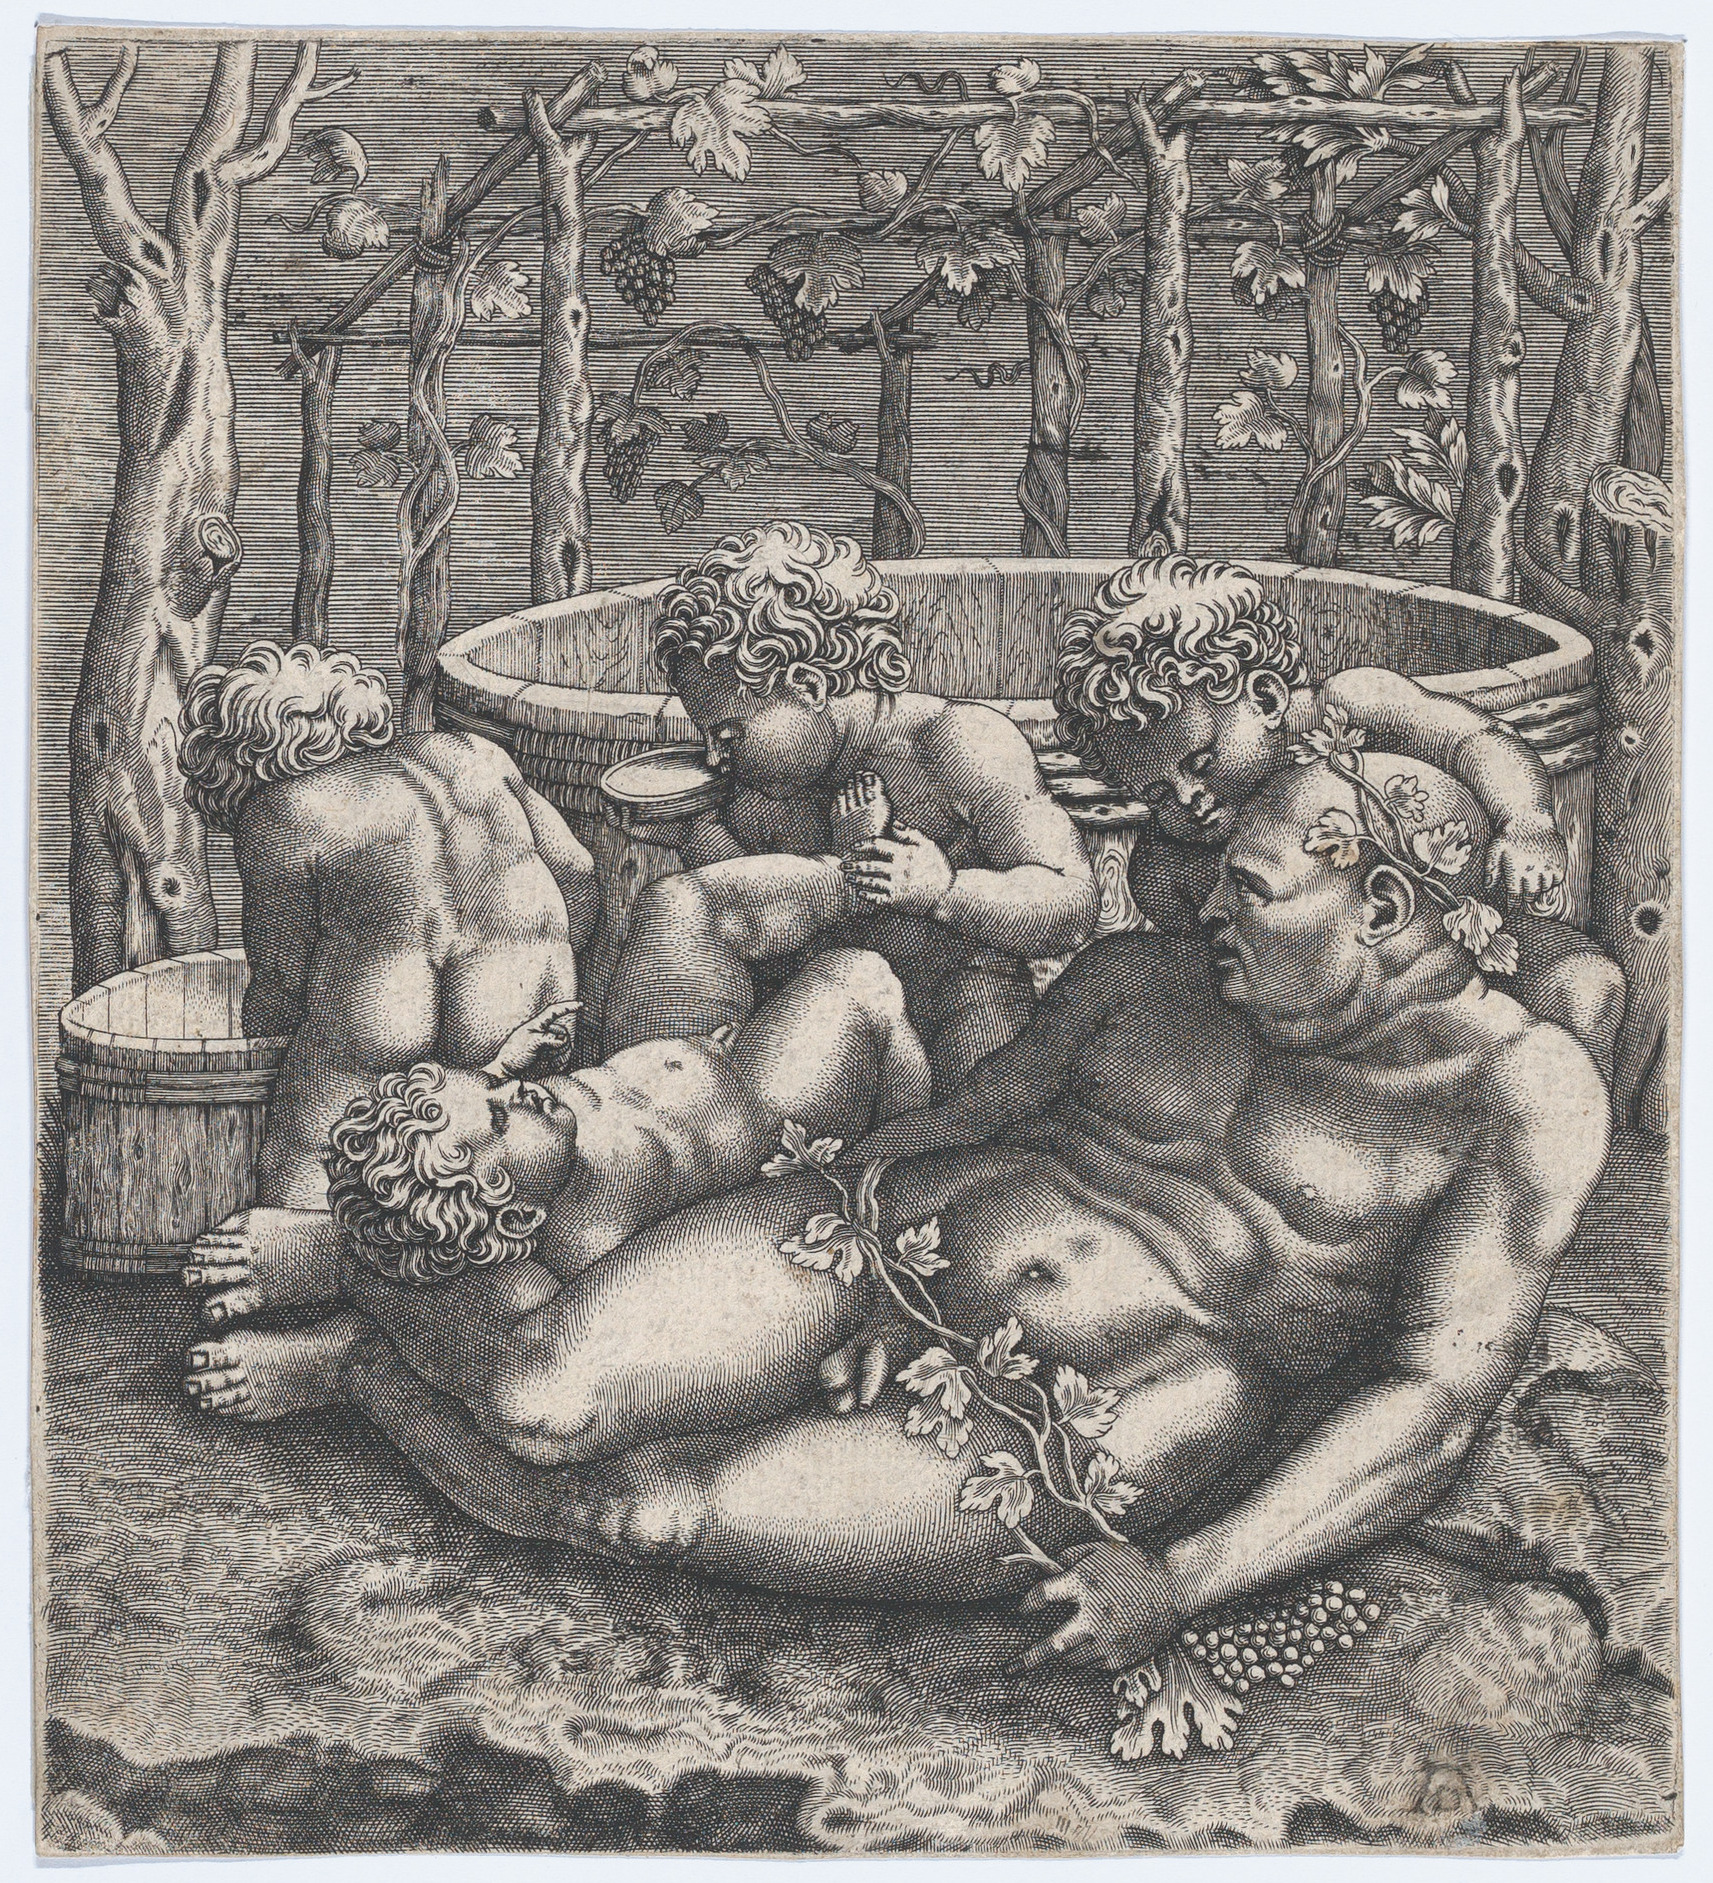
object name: print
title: The drunken Silenus with putti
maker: anonymous, italian, 16th century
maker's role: artist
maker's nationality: italian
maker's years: 1500-1600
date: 1515-1540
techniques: engraving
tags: wine,drunkenness,silenus,putti